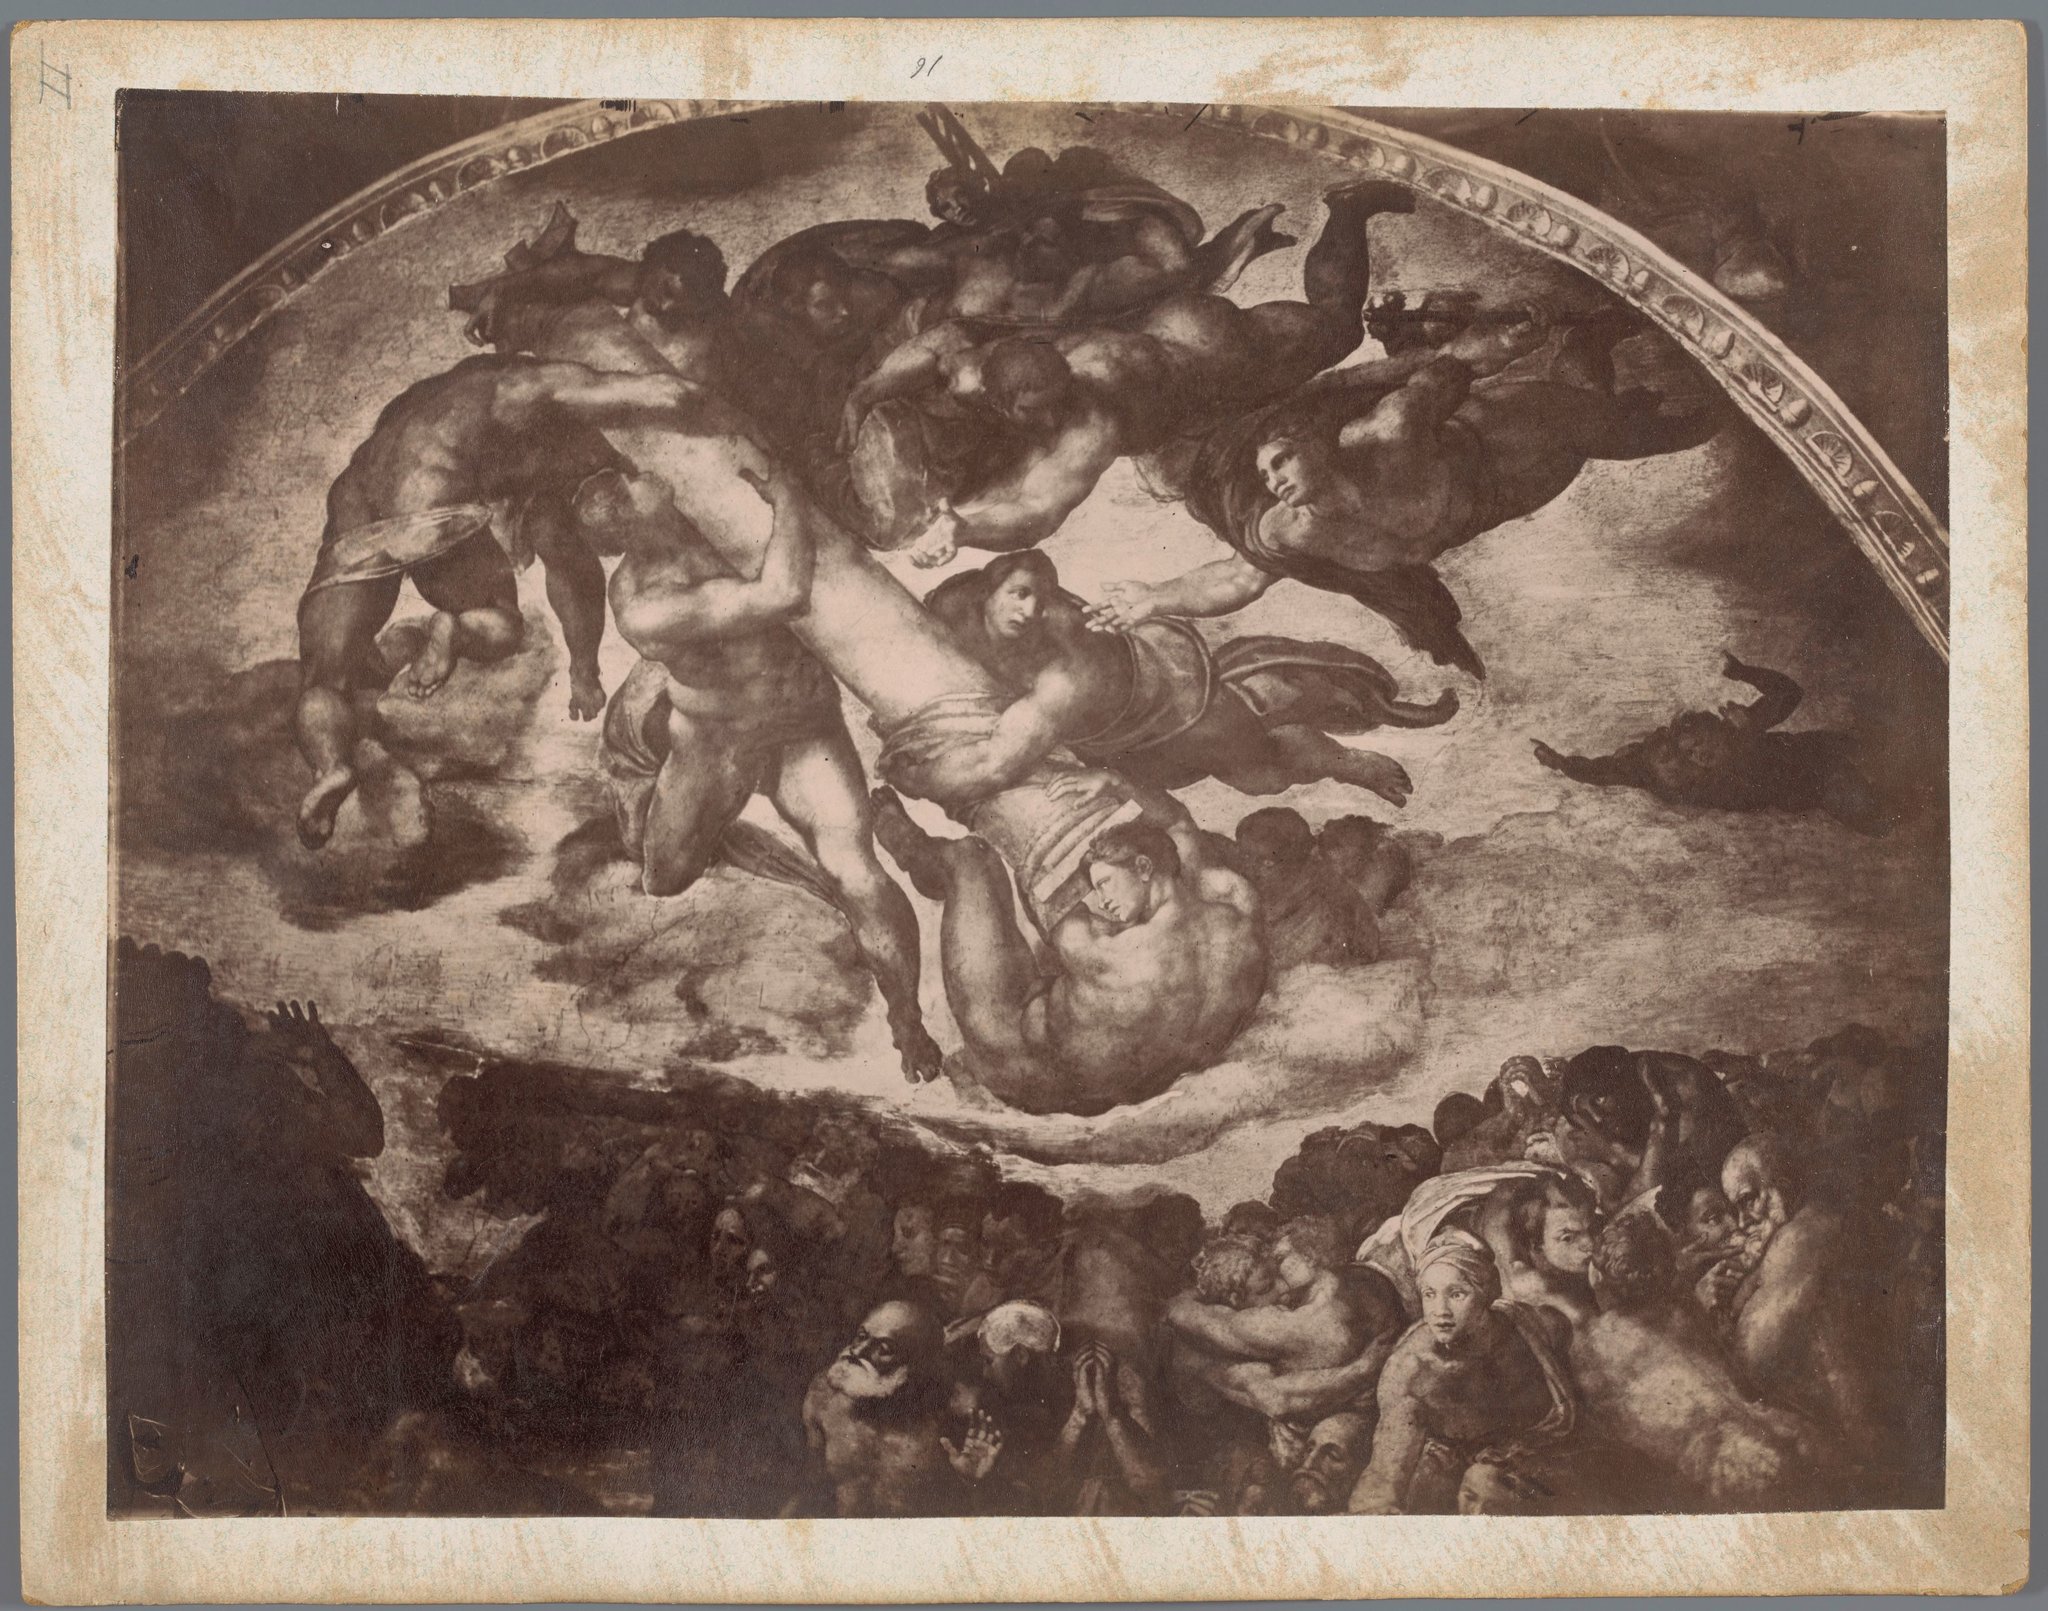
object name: reproduction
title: Fotoreproductie van een deel van de fresco's op de muur van de Sixtijnse Kapel te Vaticaanstad door Michelangelo, voorstellende engelen met de passiewerktuigen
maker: Anonymous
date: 1875-1900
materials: cardboard, photographic support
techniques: albumen print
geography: vatican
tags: column (of the flagellation) ~ instruments of the passion, last judgement, angels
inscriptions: collector's mark: Lugt 3937